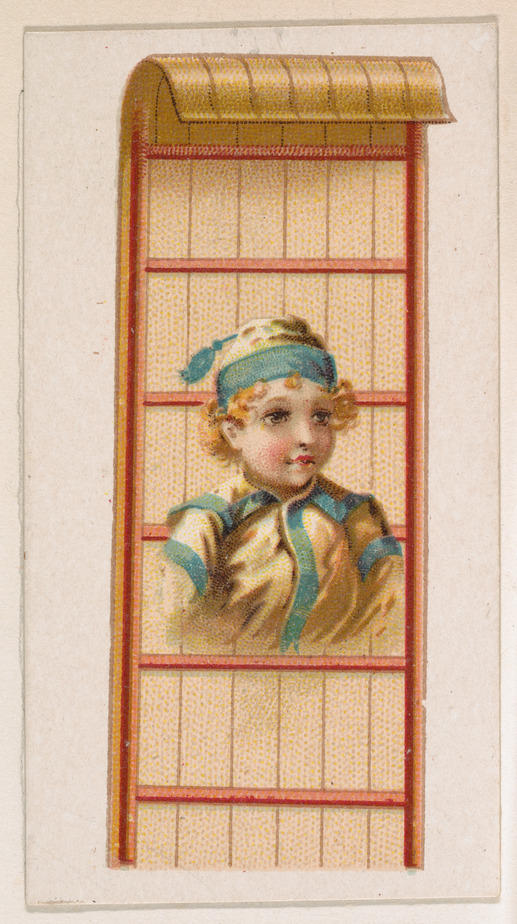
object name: print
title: Tobaggan, from the Novelties series (N228, Type 5) issued by Kinney Bros.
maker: kinney brothers tobacco company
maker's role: publisher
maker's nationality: american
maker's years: 1869-2011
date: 1889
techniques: color lithograph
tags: boys